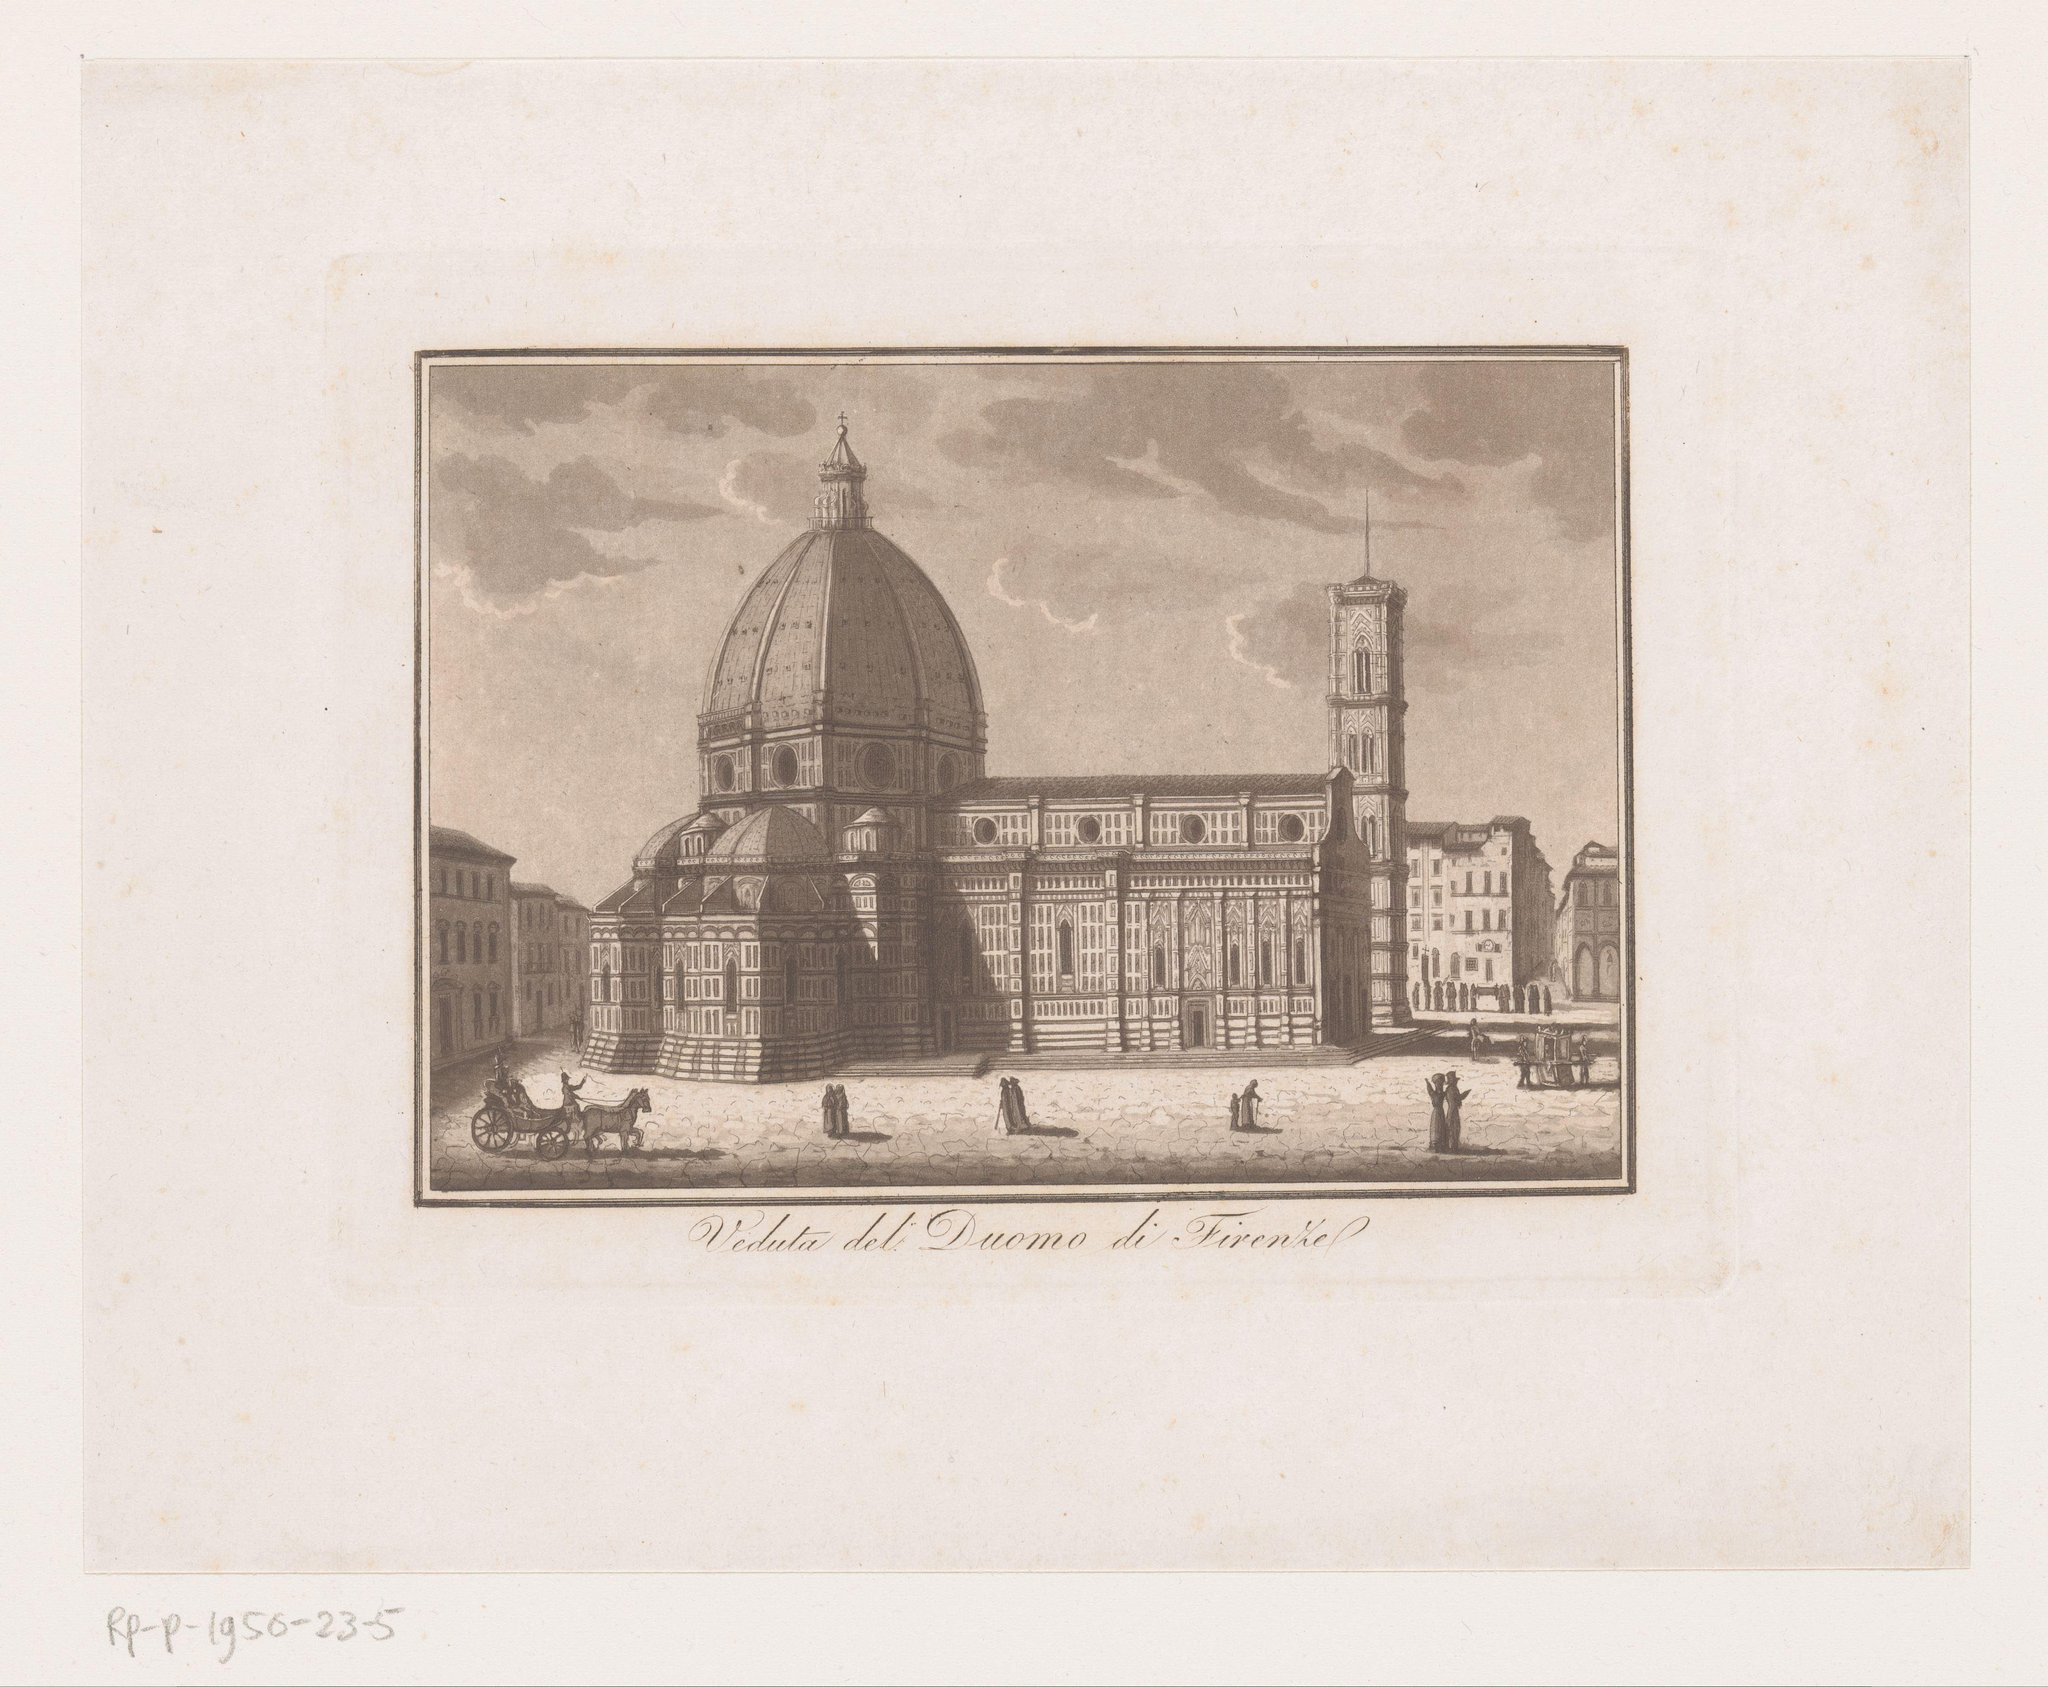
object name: print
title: Gezicht op de Kathedraal van Florence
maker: giuseppe molini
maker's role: bookseller, publisher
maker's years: 1772-1856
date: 1790-1856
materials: paper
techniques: aquatint, etching, hand coloring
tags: roman catholic church, dome ~ architecture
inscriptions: collector's mark: Lugt 2228